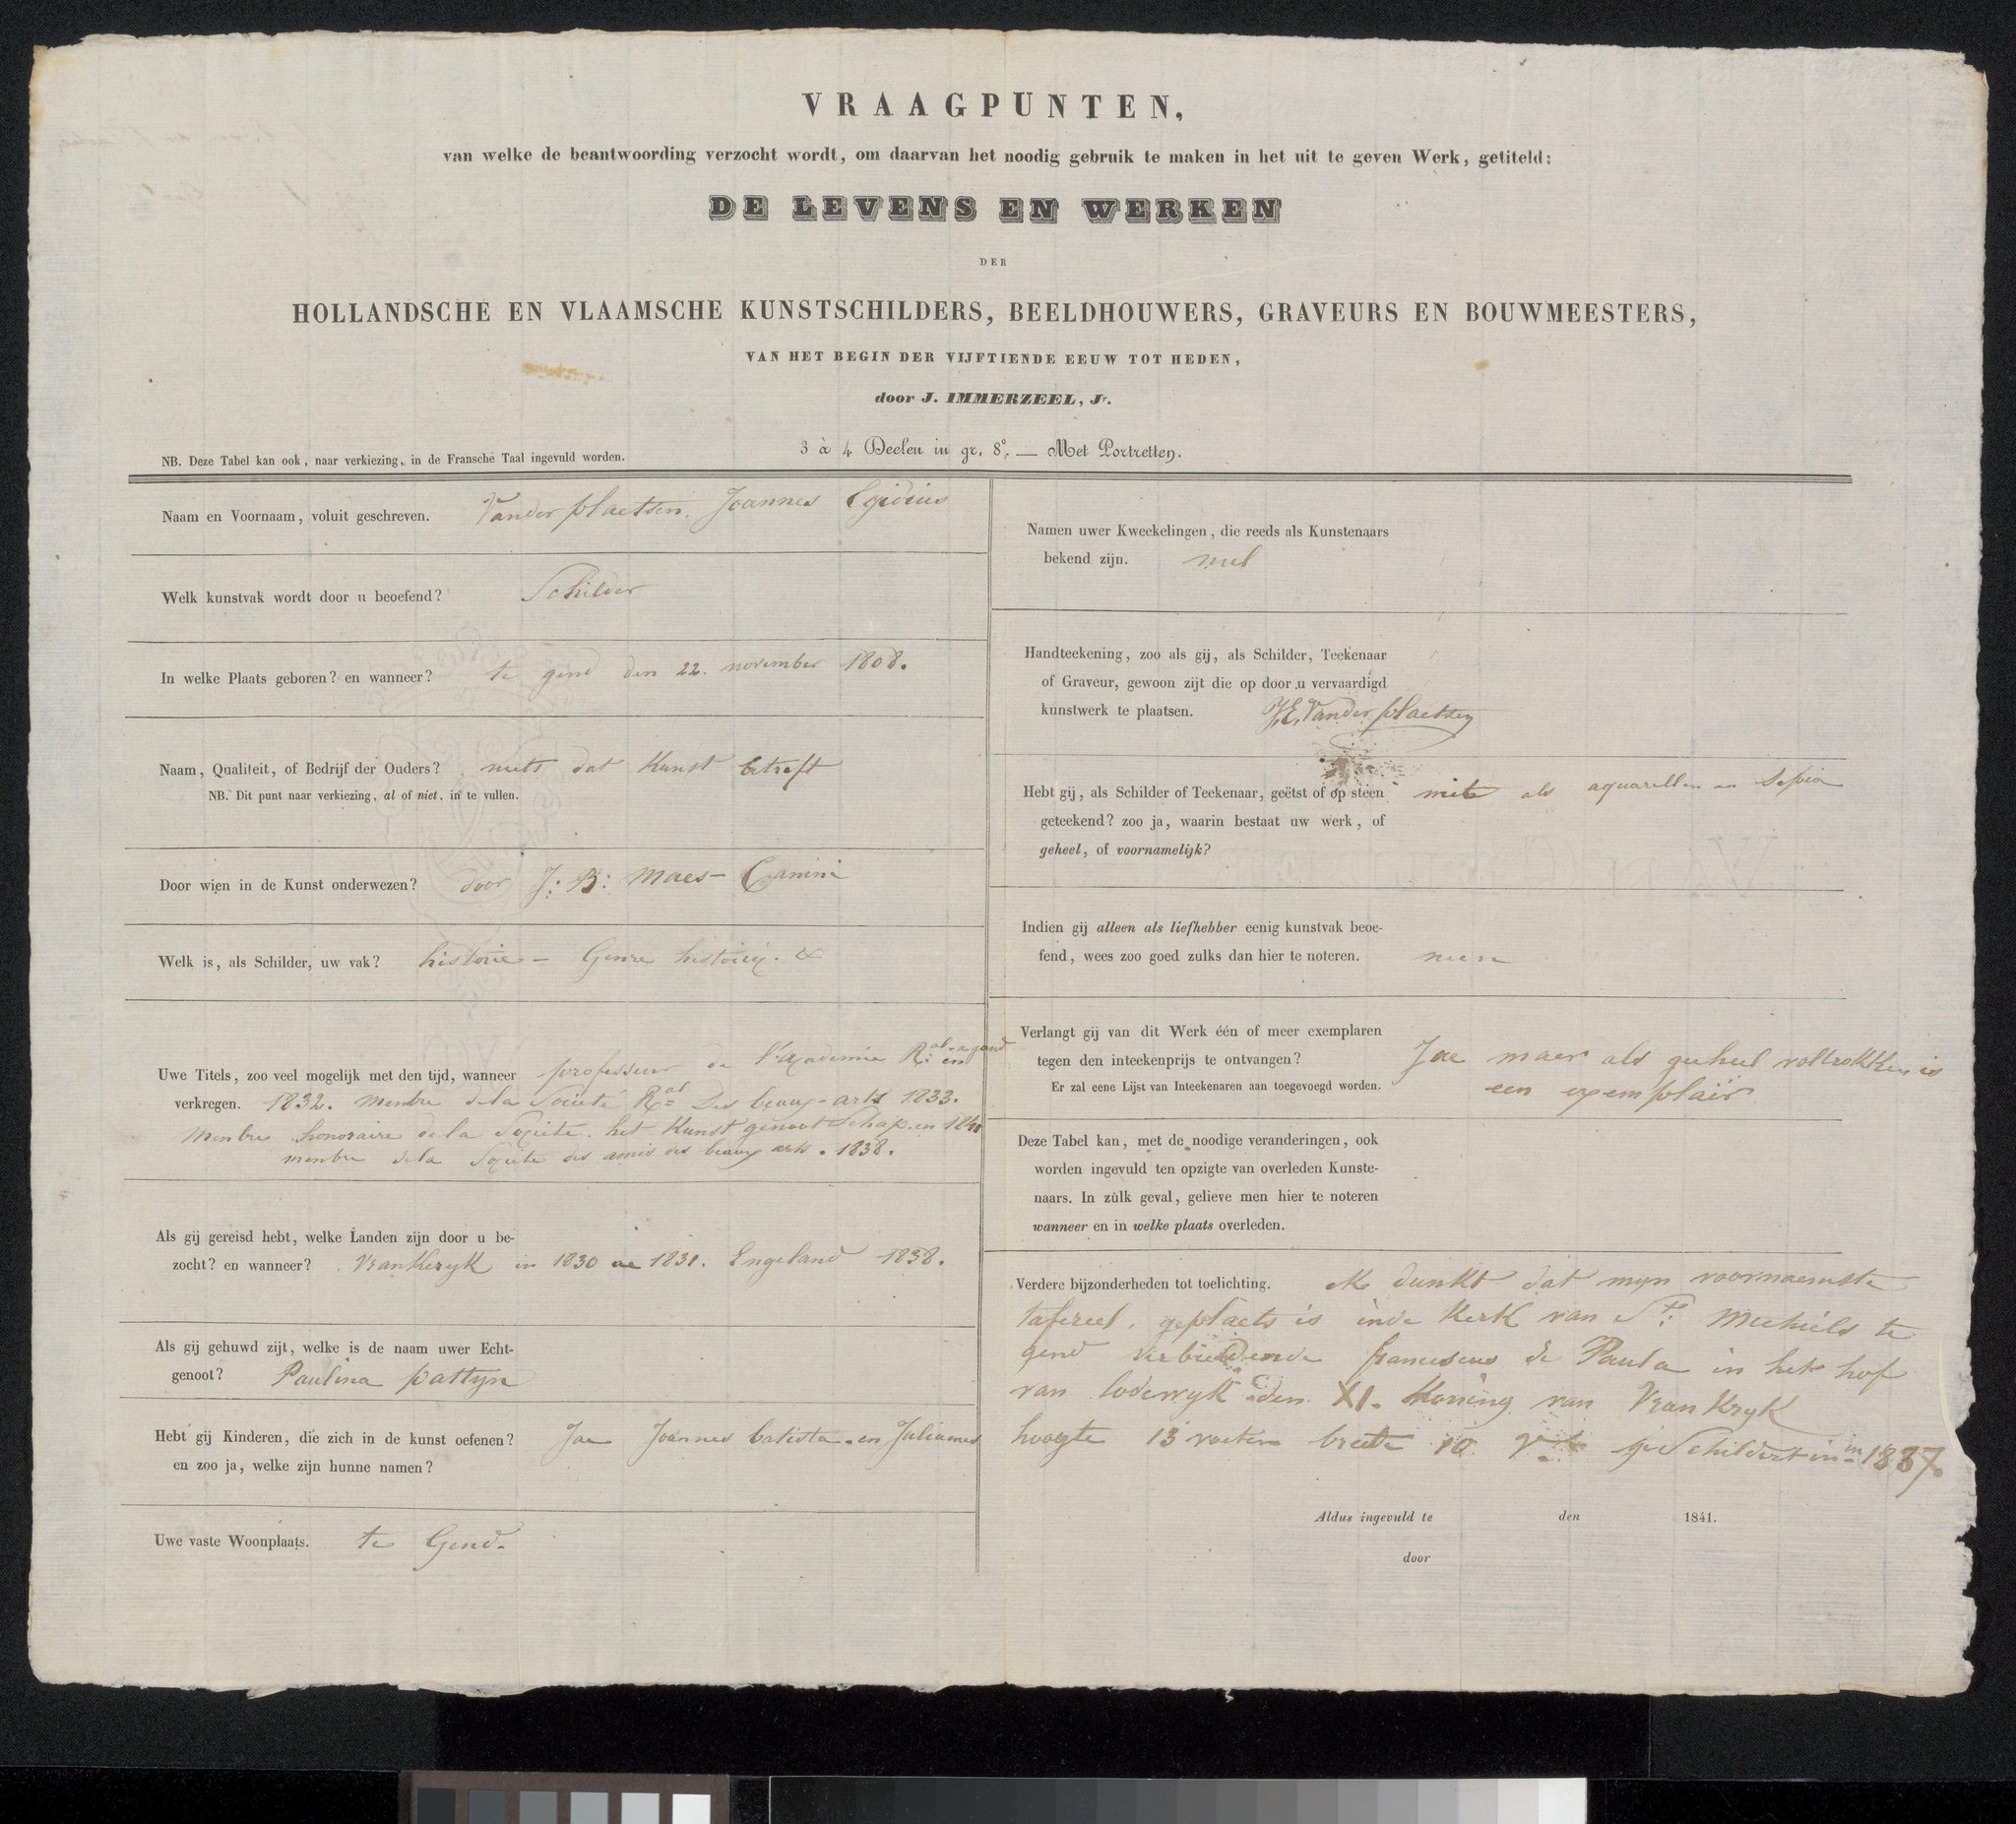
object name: manuscript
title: Enquêteformulier ingevuld door Jean Van der Plaetsen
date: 1840-1841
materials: ink, paper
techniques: pen, printing, writing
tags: ghent, painter, jean van der plaetsen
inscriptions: inscription: ‘Vraagpunten,/ van welke de beantwoording verzocht wordt, om daarvan het noodig gebruik te maken in het uit te geven Werk, getiteld: De levens en werken/ der Hollandsche en Vlaamsche kunstschilders, beeldhouwers,/ graveurs en bouwmeesters, van het begin der vijftiende eeuw tot heden/ door J. Immerzeel, Jr.’, watermark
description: Opgenomen in: Immerzeel, J. Jr., De levens en werken der Hollandsche en Vlaamsche kunstschilders, beeldhouwers, graveurs en bouwmeesters, van het begin der vijftiende eeuw tot heden, Amsterdam: J.C. van Kesteren, 1842-1843.